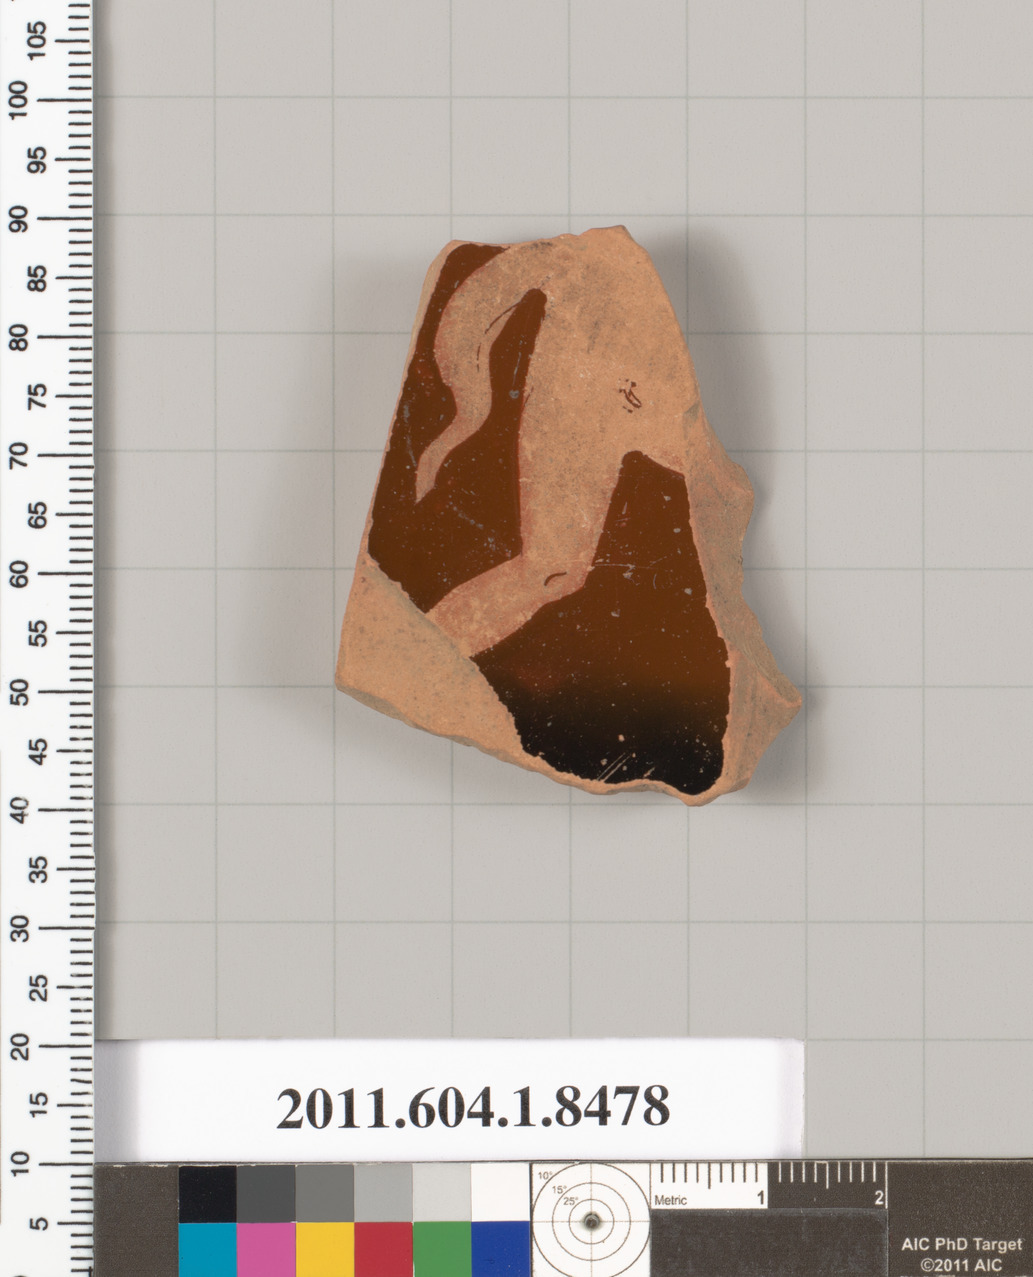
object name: kylix fragment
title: Terracotta fragment of a stemless kylix (drinking cup)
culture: greek, attic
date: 467-435 BCE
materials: terracotta